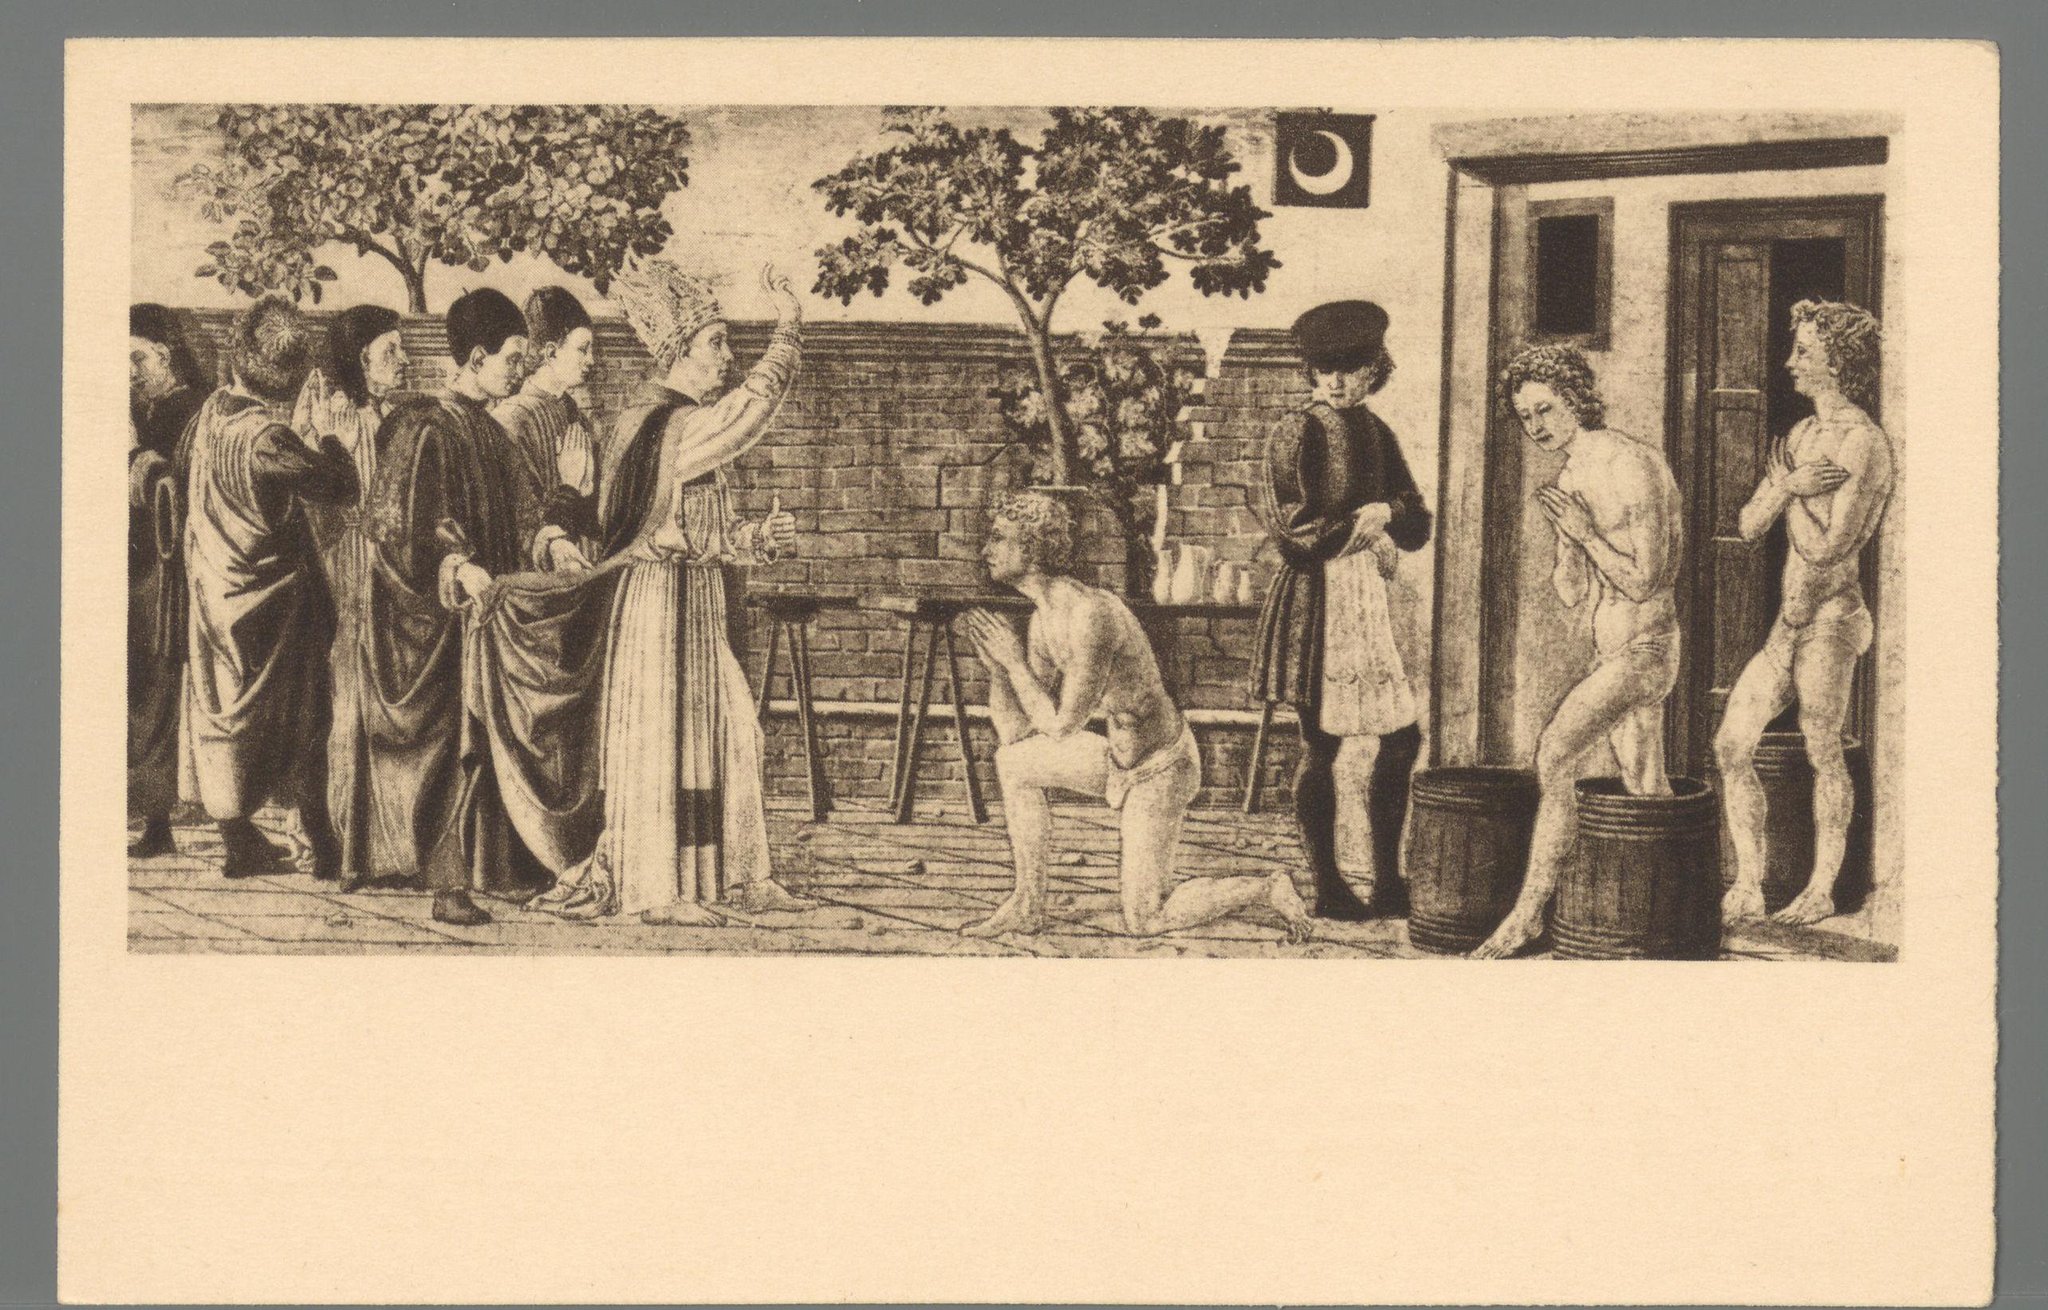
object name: ansichtkaart, prentbriefkaart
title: Francesco Pesellino (c. 1422-1457). De H. Nicolaas schenkt het leven terug aan drie vermoorde knapen - Florence, Galleria Buonarroti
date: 1928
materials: cardboard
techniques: rotogravure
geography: milan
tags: permanent exhibition, museum, picture, painting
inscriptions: collector's mark: ‘AFE v S’